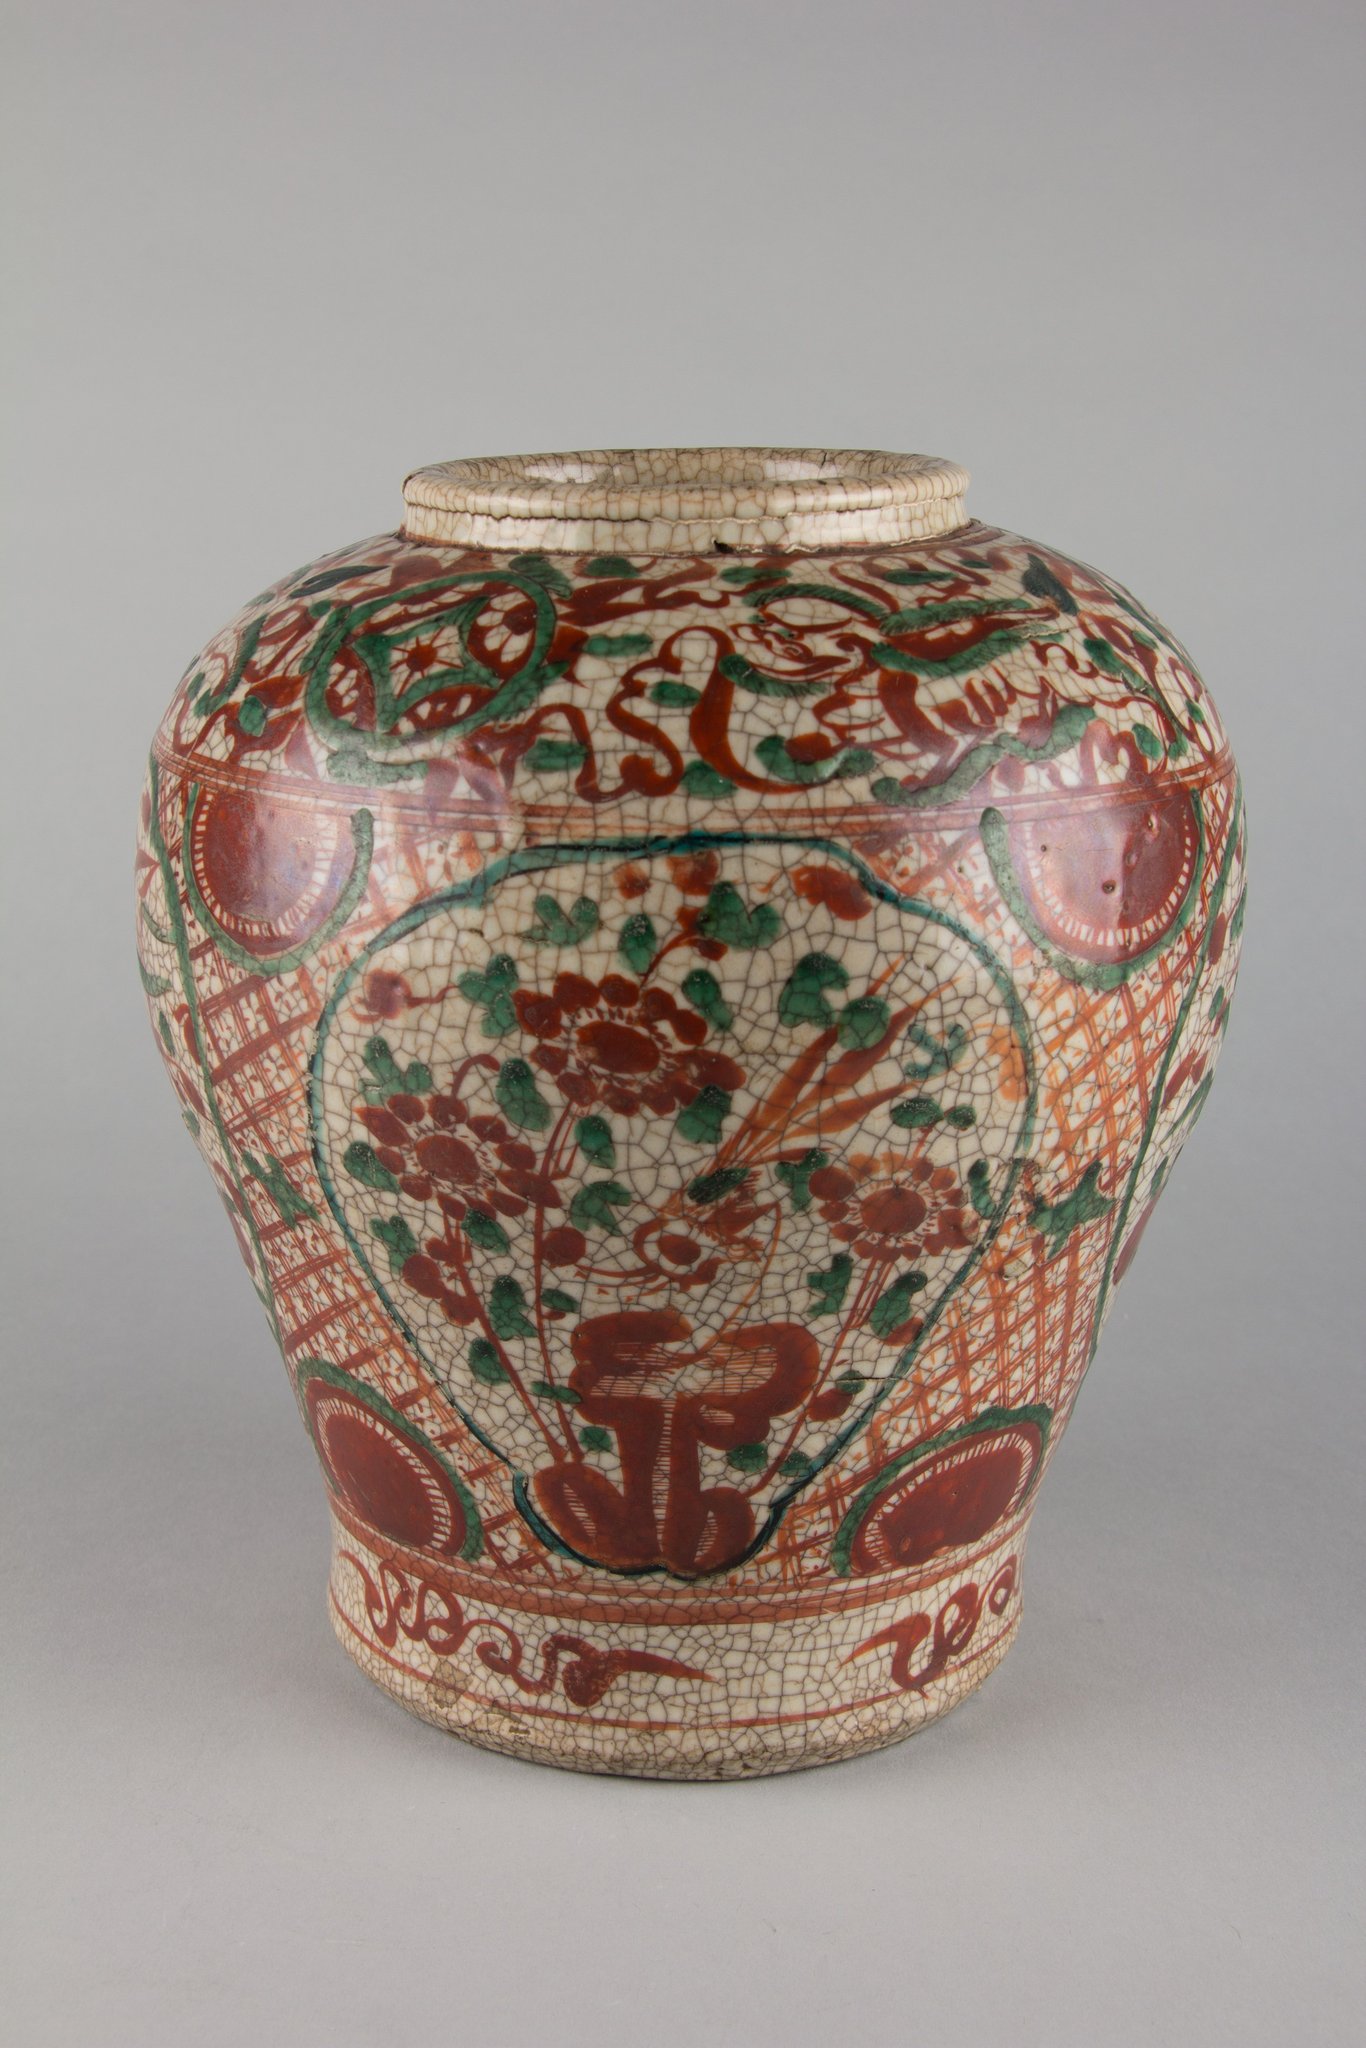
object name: jar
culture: chinese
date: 1573-1620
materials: porcelain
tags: flowers